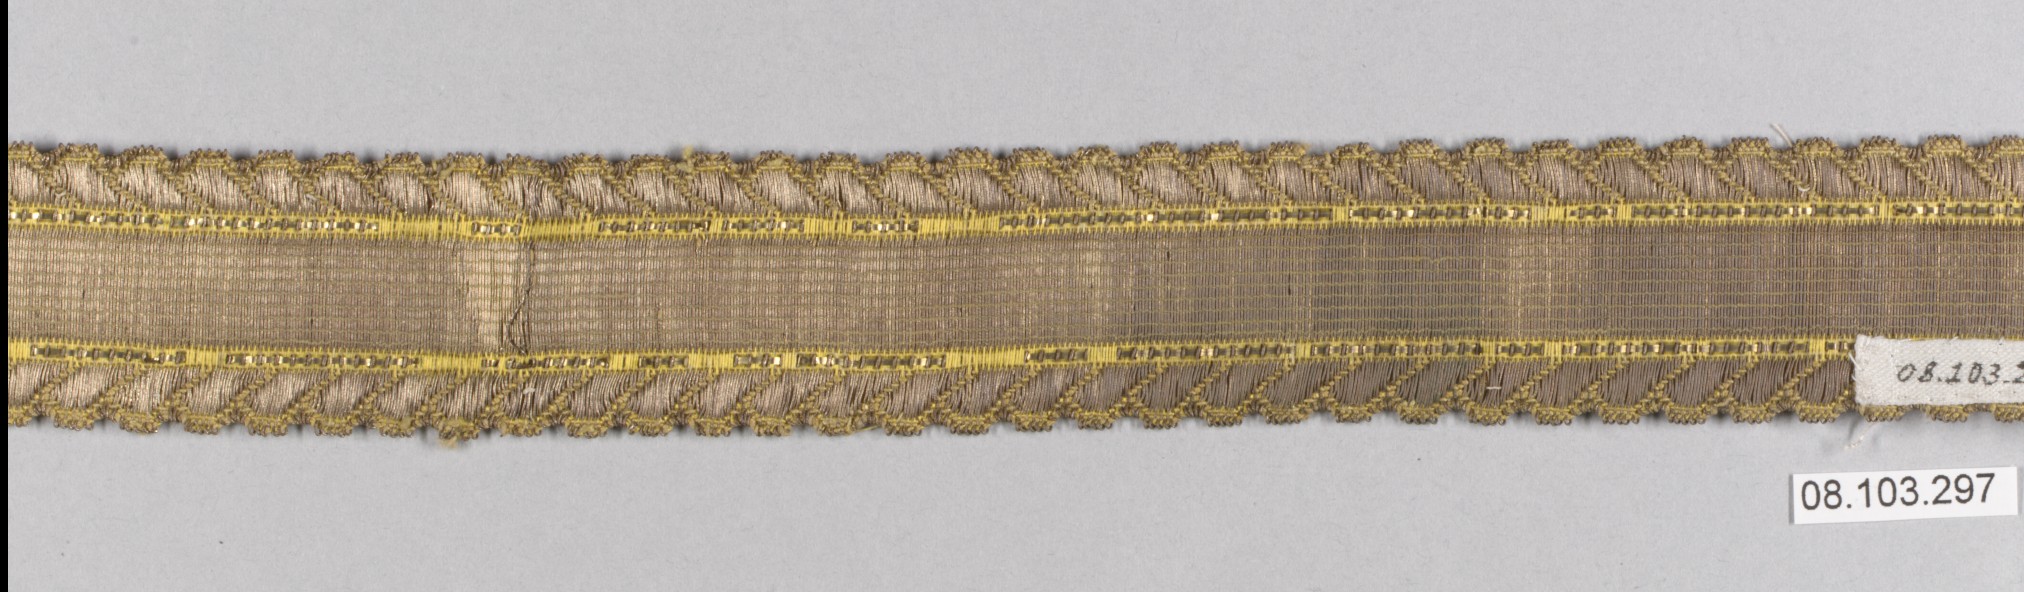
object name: galloon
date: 1601-1800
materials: metal thread, silk